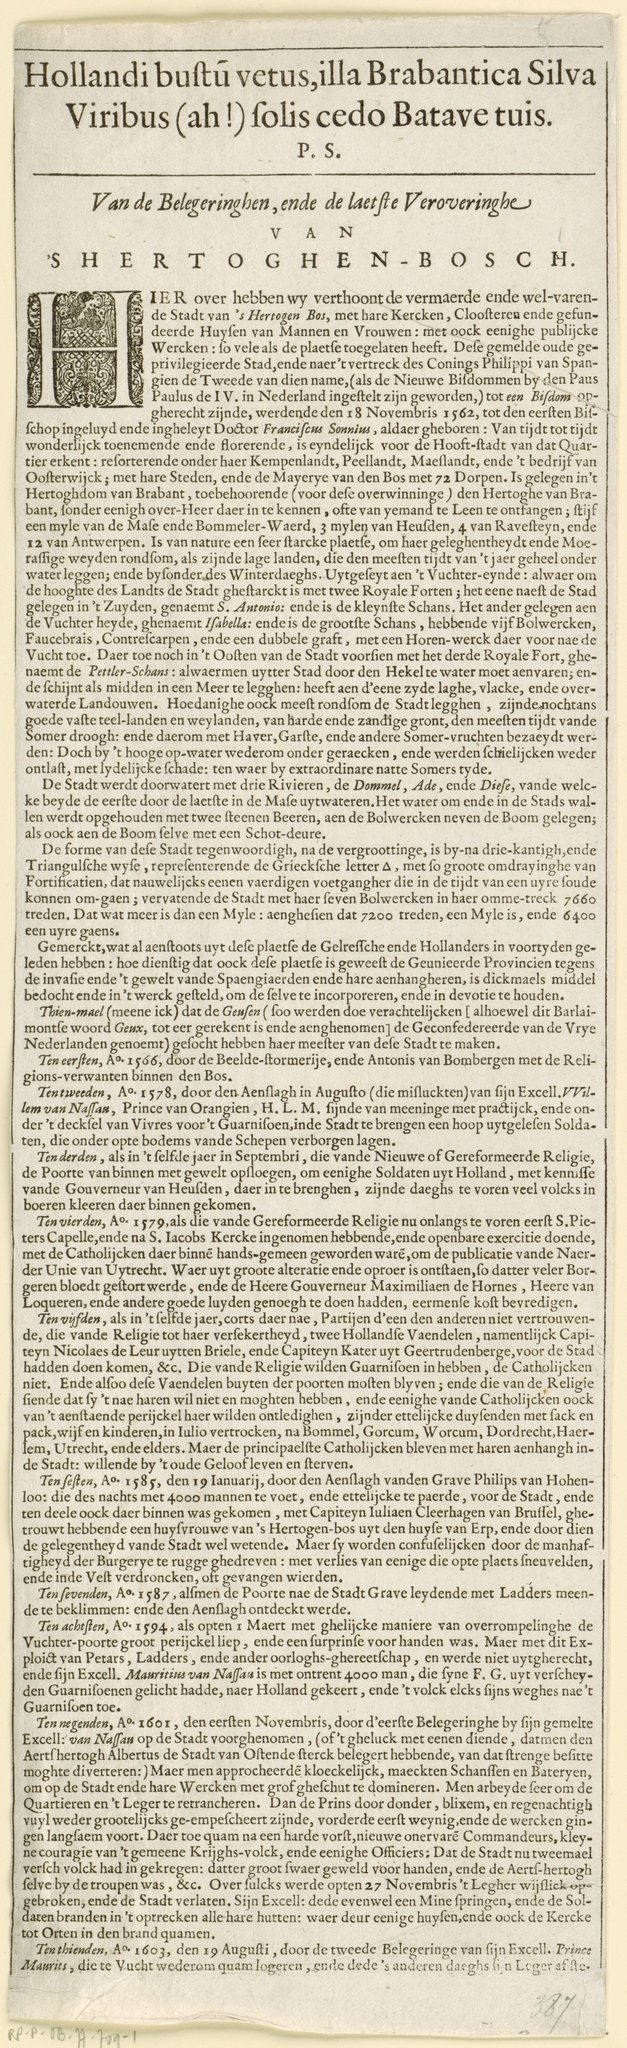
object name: print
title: Beleg en inname van Den Bosch door Frederik Hendrik, 1629, (tekstblad)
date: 1630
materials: paper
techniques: letterpress printing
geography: amsterdam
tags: frederick henry (prince of orange), den bosch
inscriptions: date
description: Tekstblad bij de grote kaart van de omsingeling van Den Bosch tijdens het beleg door het Staatse leger onder Frederik Hendrik, van 1 mei tot 17 september 1629. Geheel bestaande uit 4 platen en 4 tekstbladen. Tekstblad in het Nederlands met een beschrijving van de belegering en verovering van de stad. Bovenaan twee regels in het Latijn.